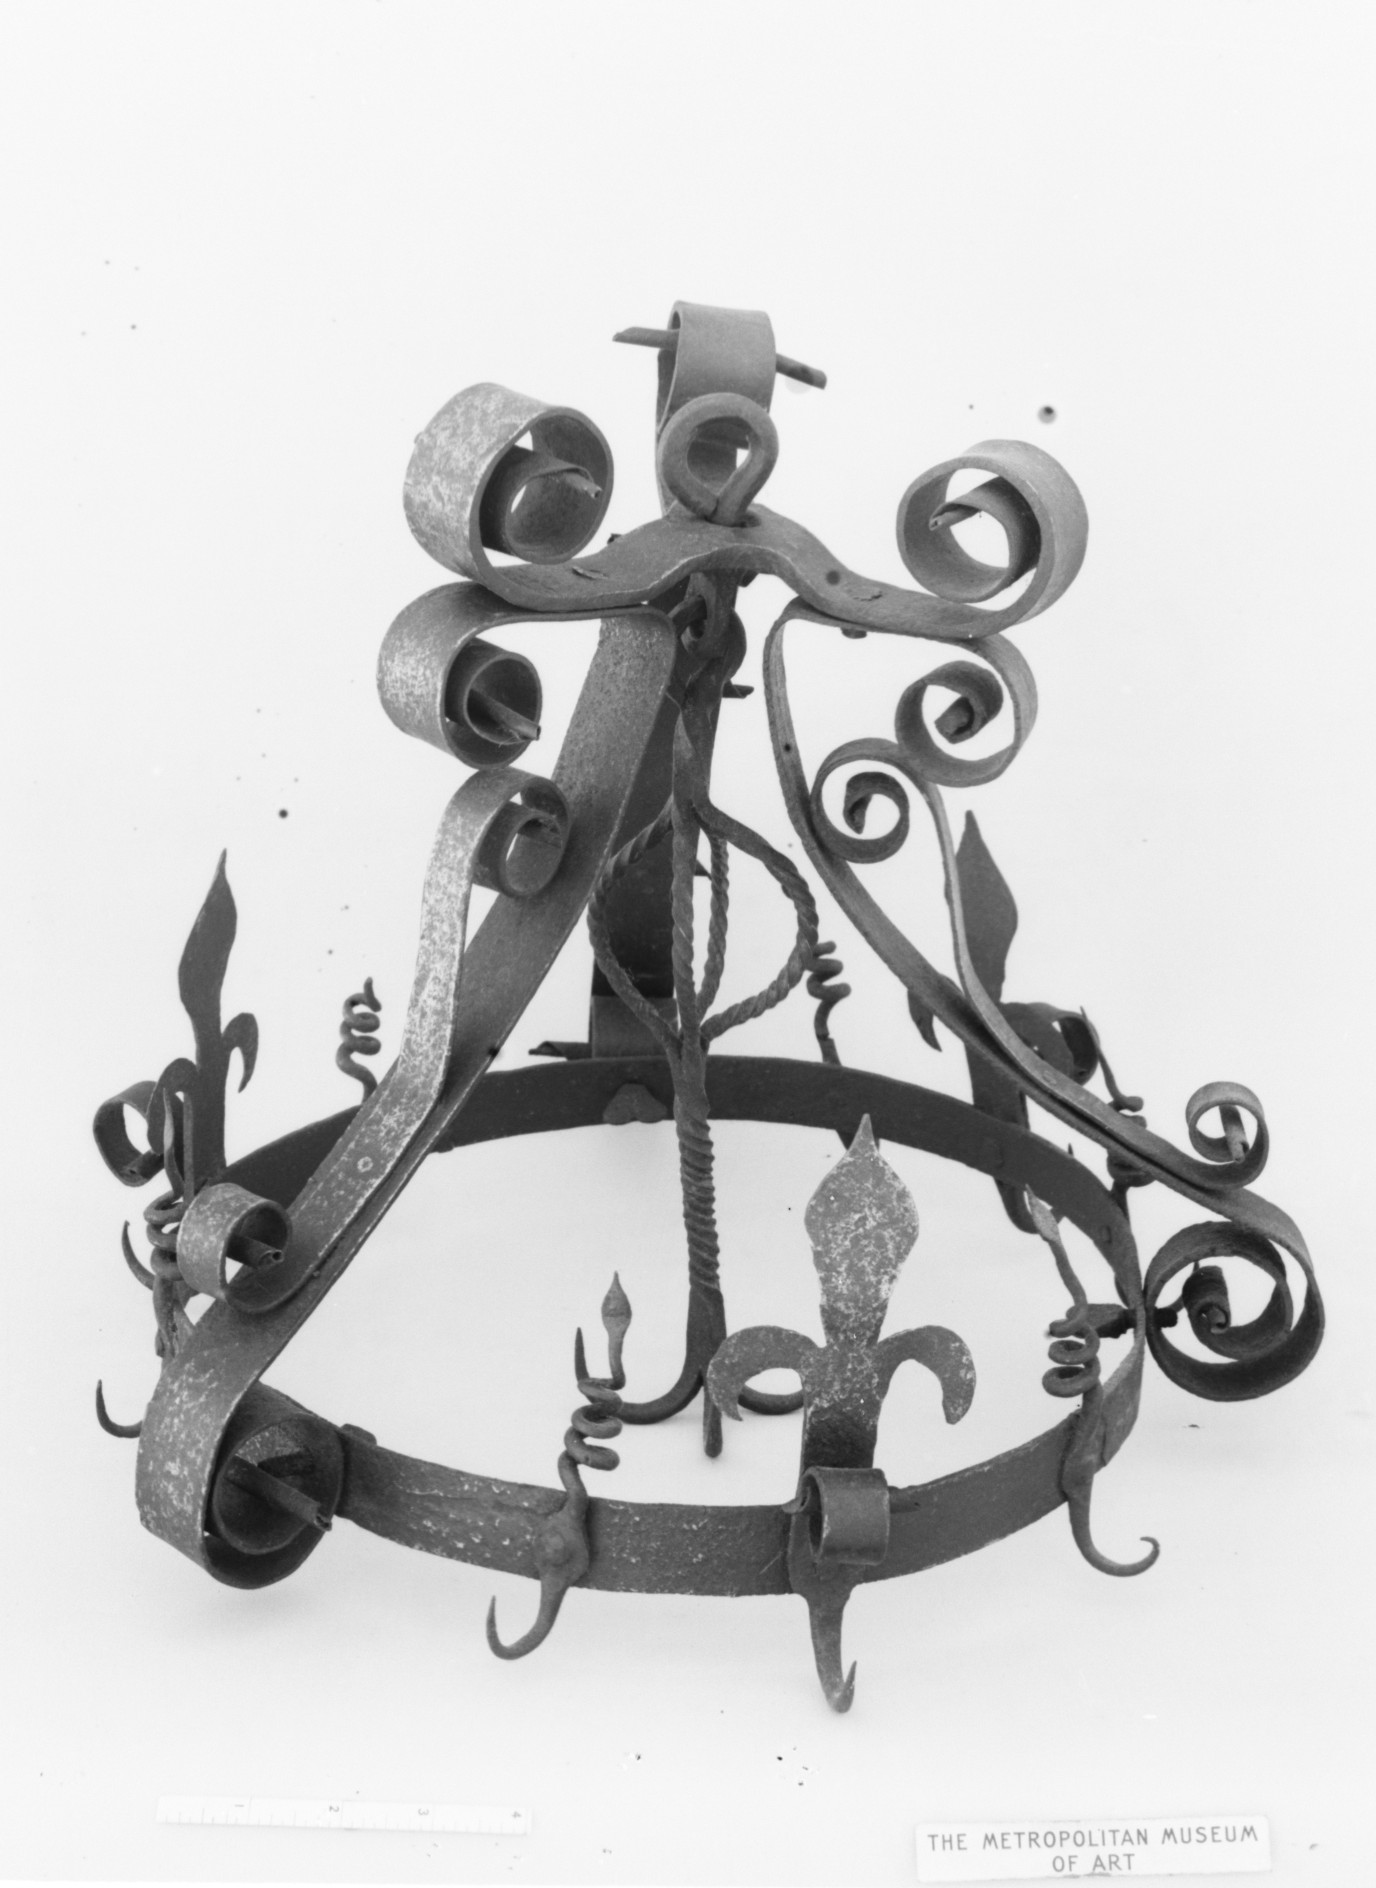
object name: game rack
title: Game rack (Couronne D'office)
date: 1601-1700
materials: iron